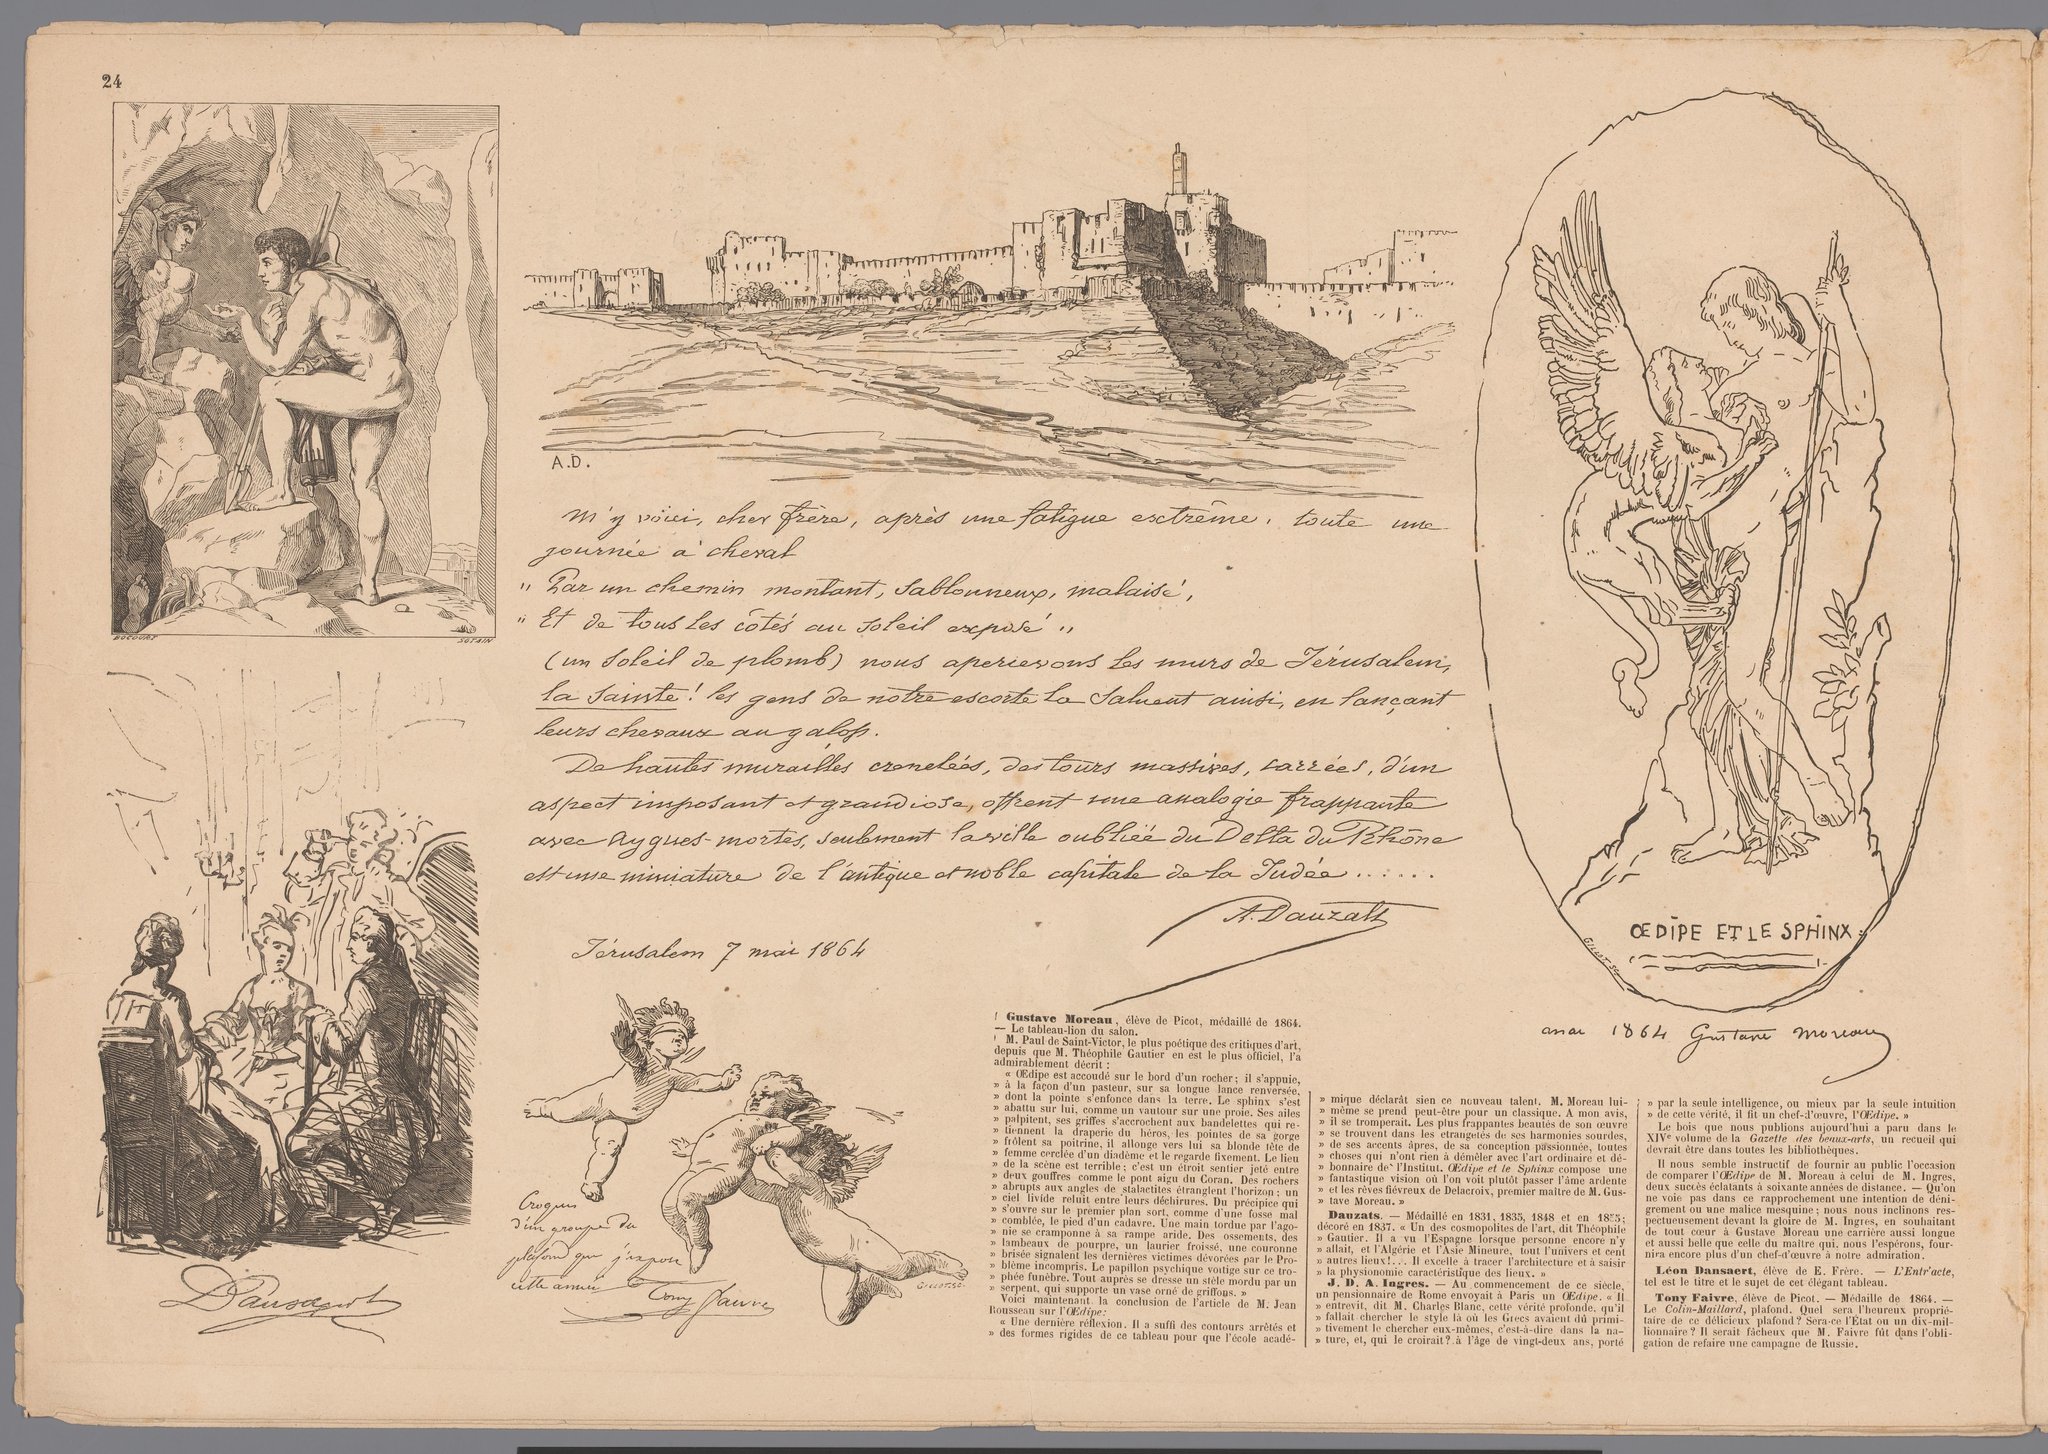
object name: print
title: Oedipus en de sfinx, gezicht op een stadsmuur, gezelschap in een interieur en drie putti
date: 1864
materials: paper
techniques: gillotage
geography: paris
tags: city-view in general; 'veduta', oedipus and the sphinx; he solves the riddle, cupids: 'amores', 'amoretti', 'putti'